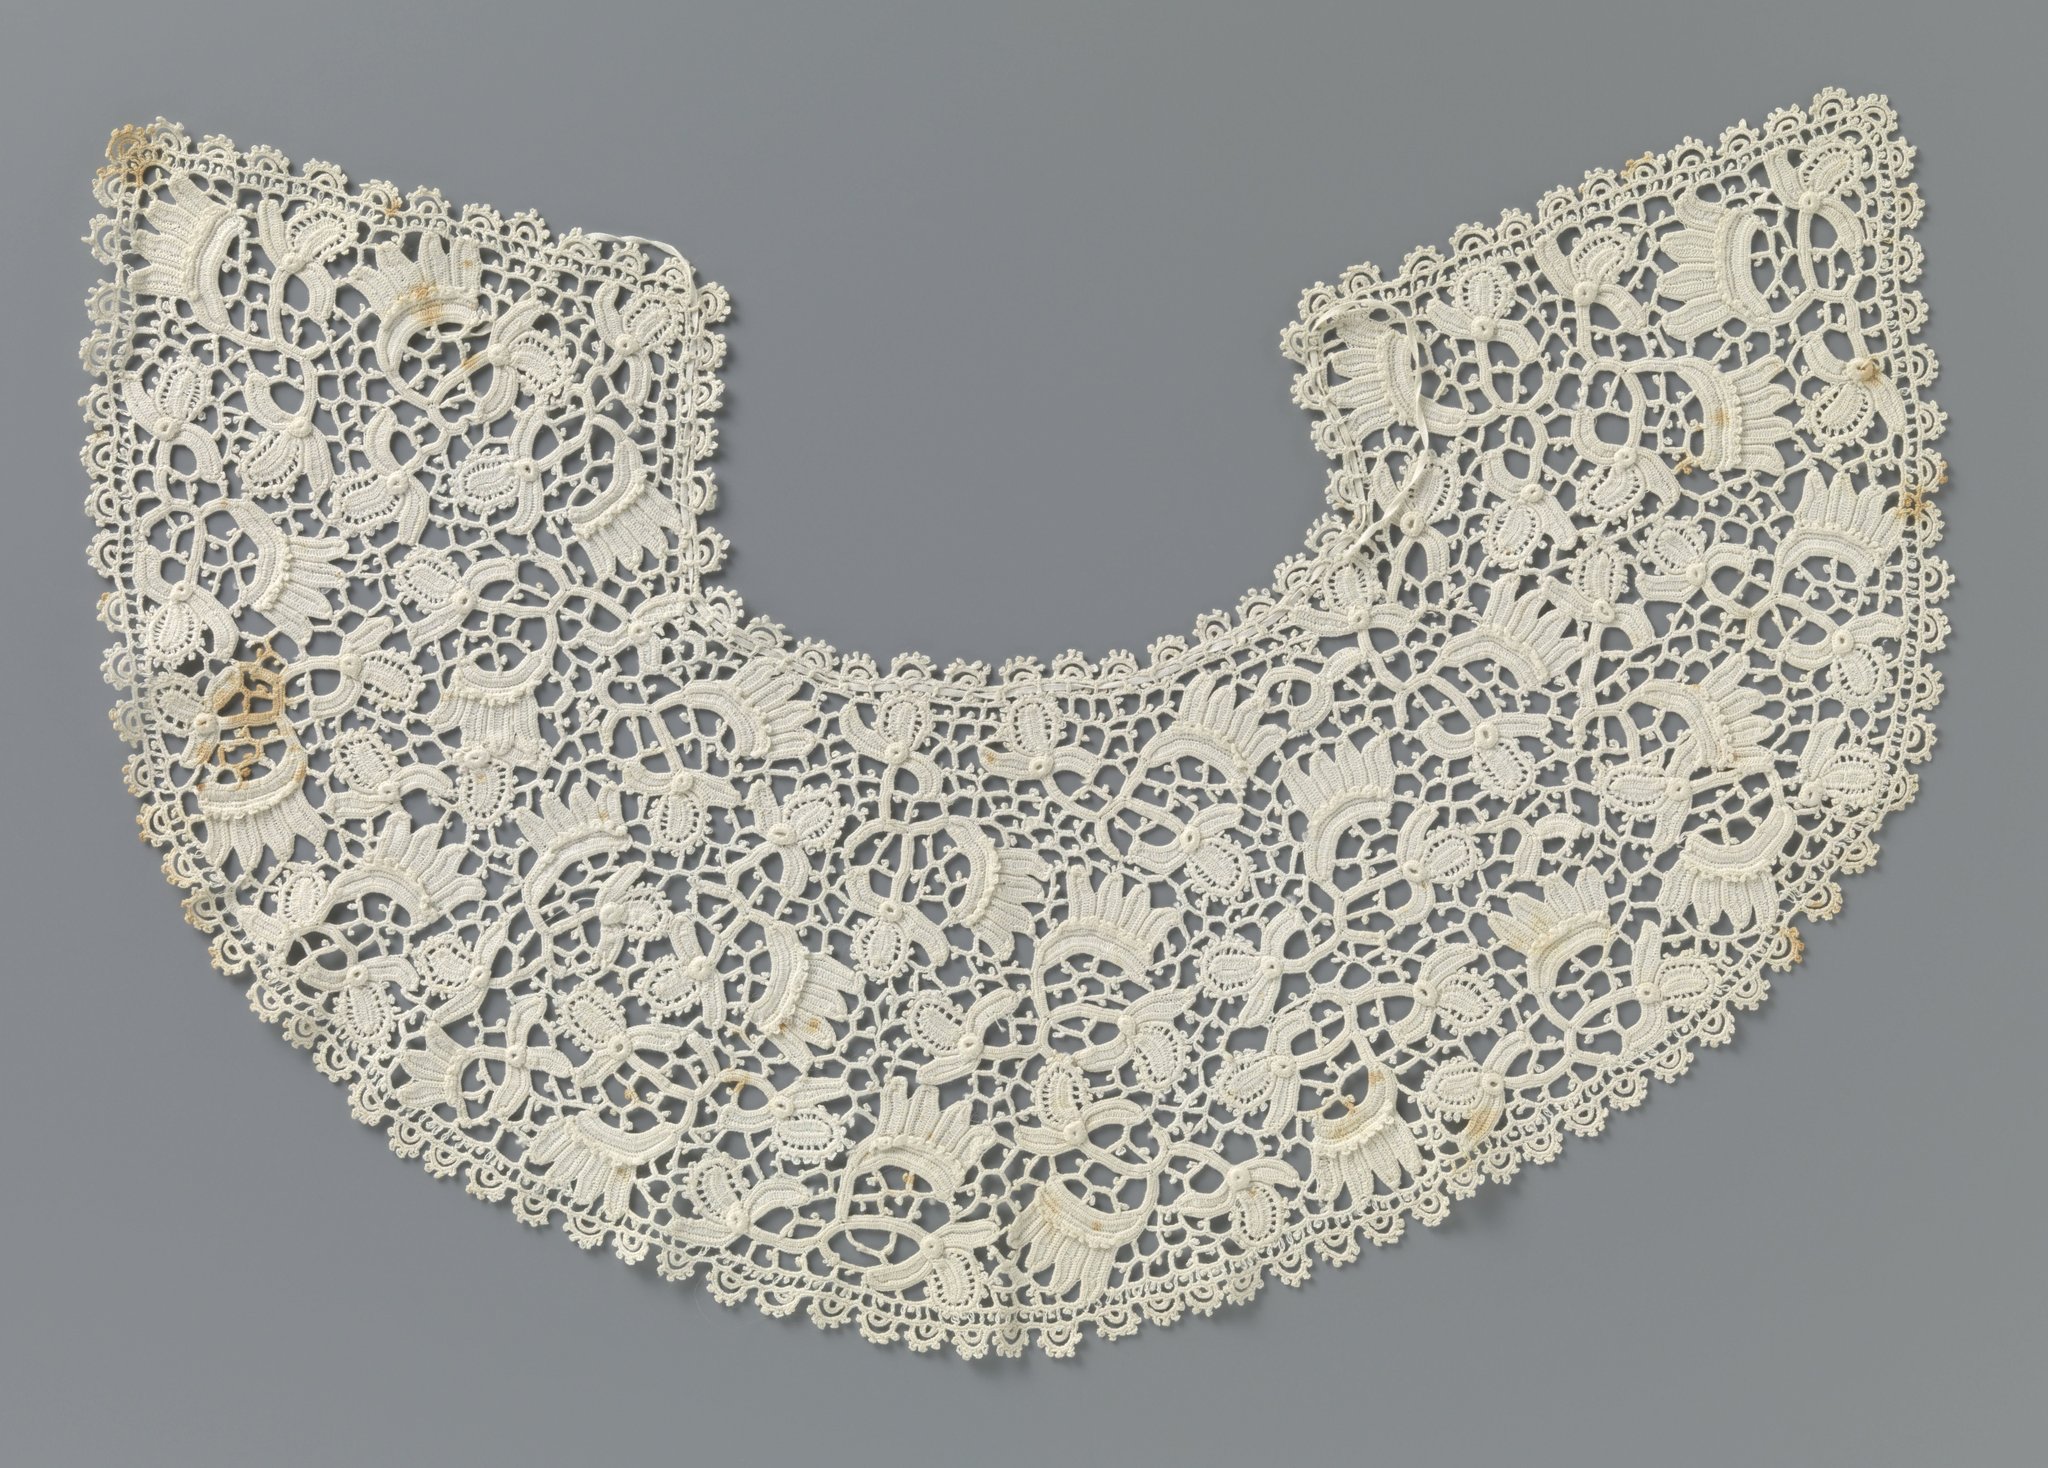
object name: collar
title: Kraag van gehaakte kant met borstelachtige bladeren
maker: Anonymous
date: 1890-1909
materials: cotton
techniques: crocheted lace, irish crochet lace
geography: ireland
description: Het is een aanname dat deze Ierse gehaakte kant ook daadwerkelijk in Ierland is gemaakt. Ierse gehaakte kant kent zijn oorsprong rond 1760 en kwam vanaf 1840 in ontwikkeling. Aangezien volgens Martine Bruggeman (Kant in Europa) de Ierse haakindustrie aan het eind van de 19e eeuw gereorganiseerd werd en in populariteit groeide, is het hier beschreven stuk gedateerd rond 1890, tot 1909 vanwege de datering in het eerste decennium van populariteit van Ierse gehaakte kant volgens het Kantlexicon (Johan Coene).